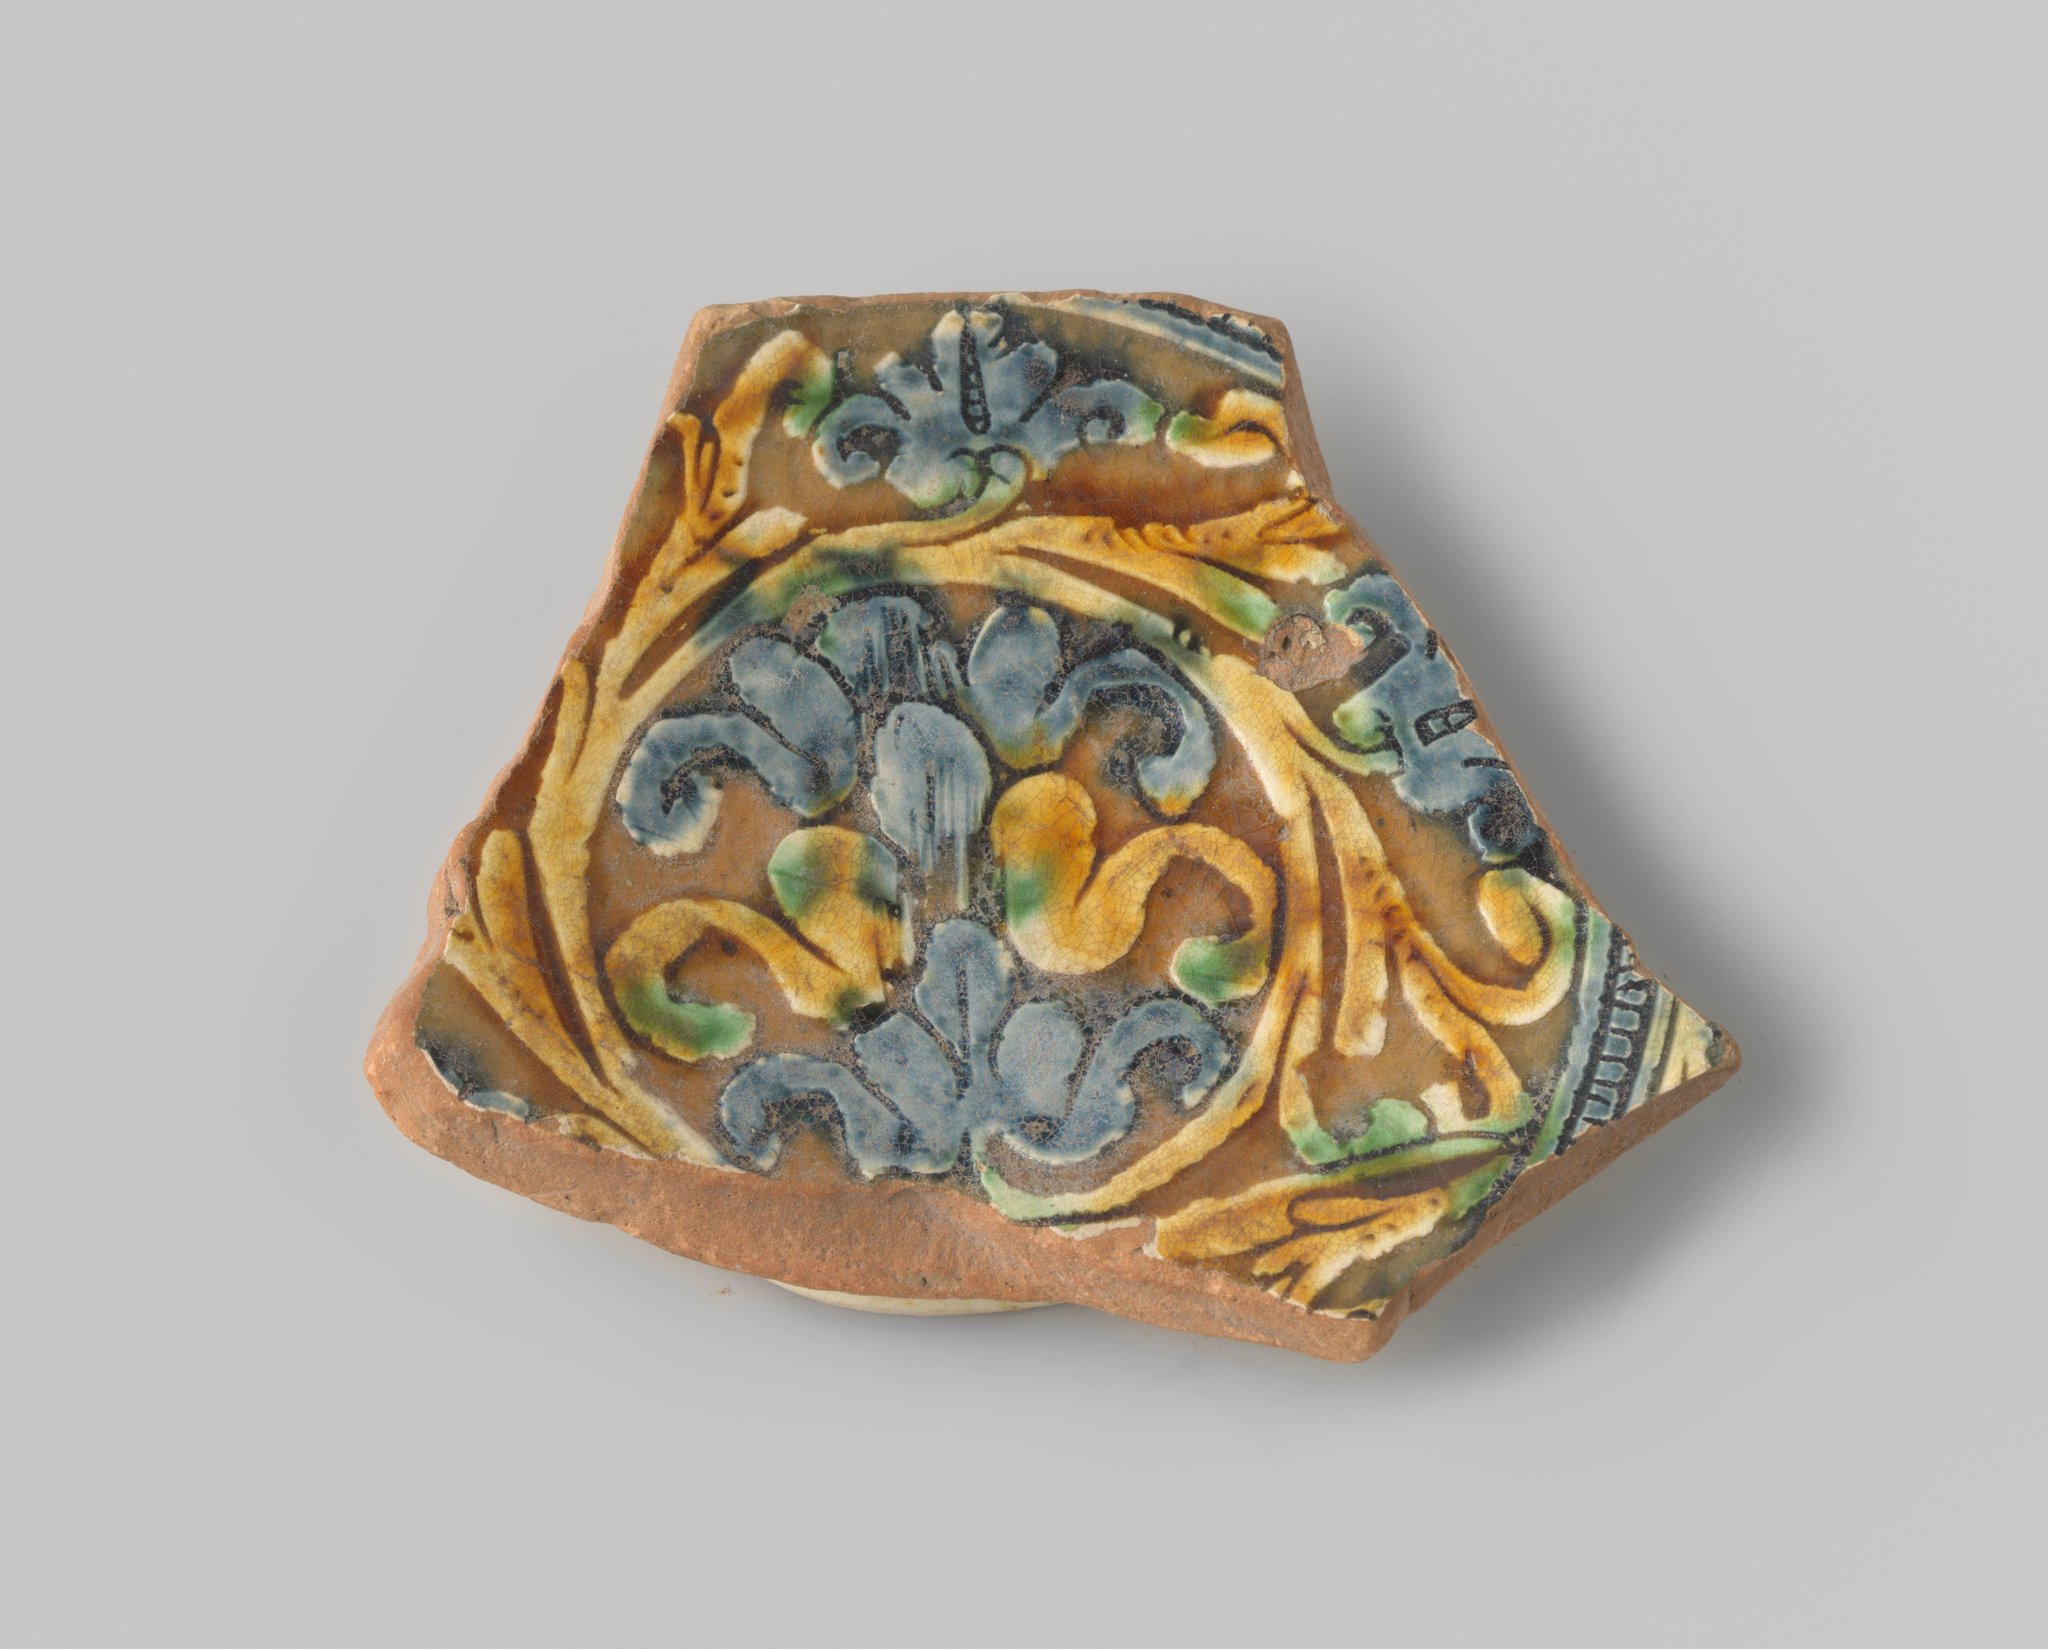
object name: sherd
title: Fragment (voet) met rode scherf, met een decoratie van florale vormen in blauw, geel en groen aan de bovenzijde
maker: Anonymous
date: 1200-1899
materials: earthenware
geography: italy